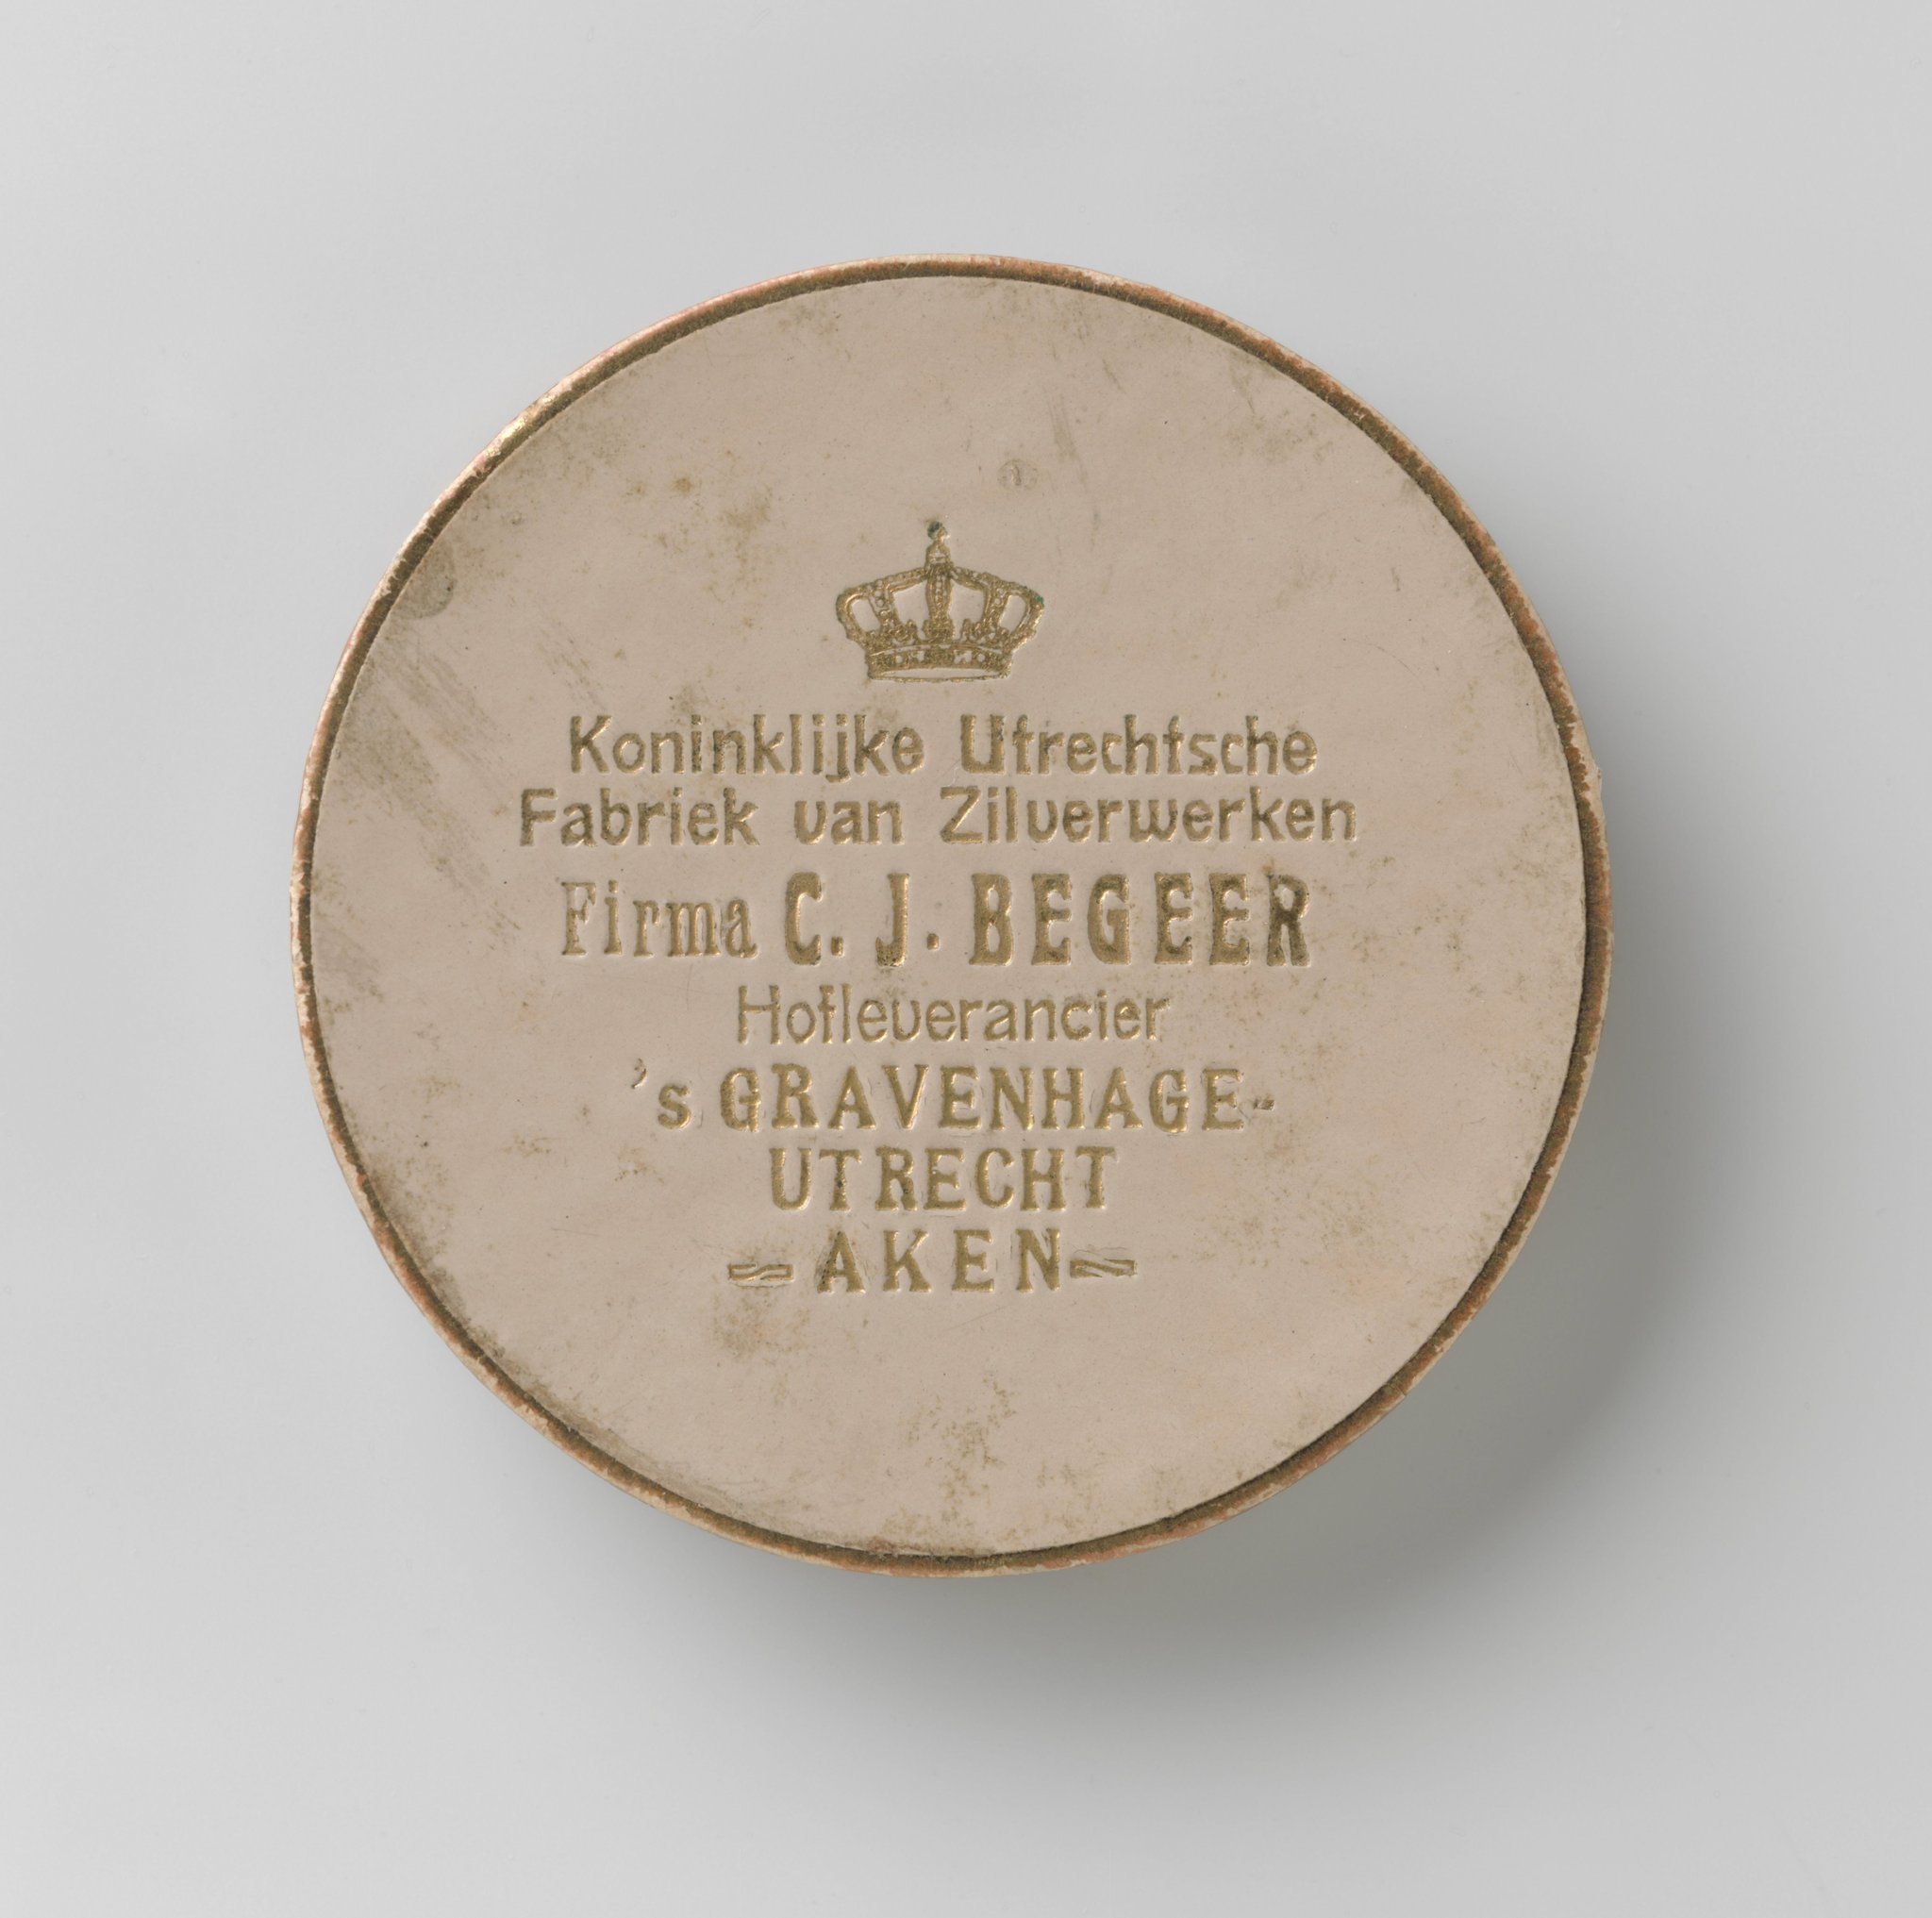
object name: medal box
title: Penningdoos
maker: Anonymous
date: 1912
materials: leather, velvet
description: Penningdoos van karton, deksel beplakt met rozekleurig papier met tekst in gouden letters (fabrikant), binnenzijde deksel en doos bekleed met rood fluweel. Met bijbehorende penning NG-2012-58-1.